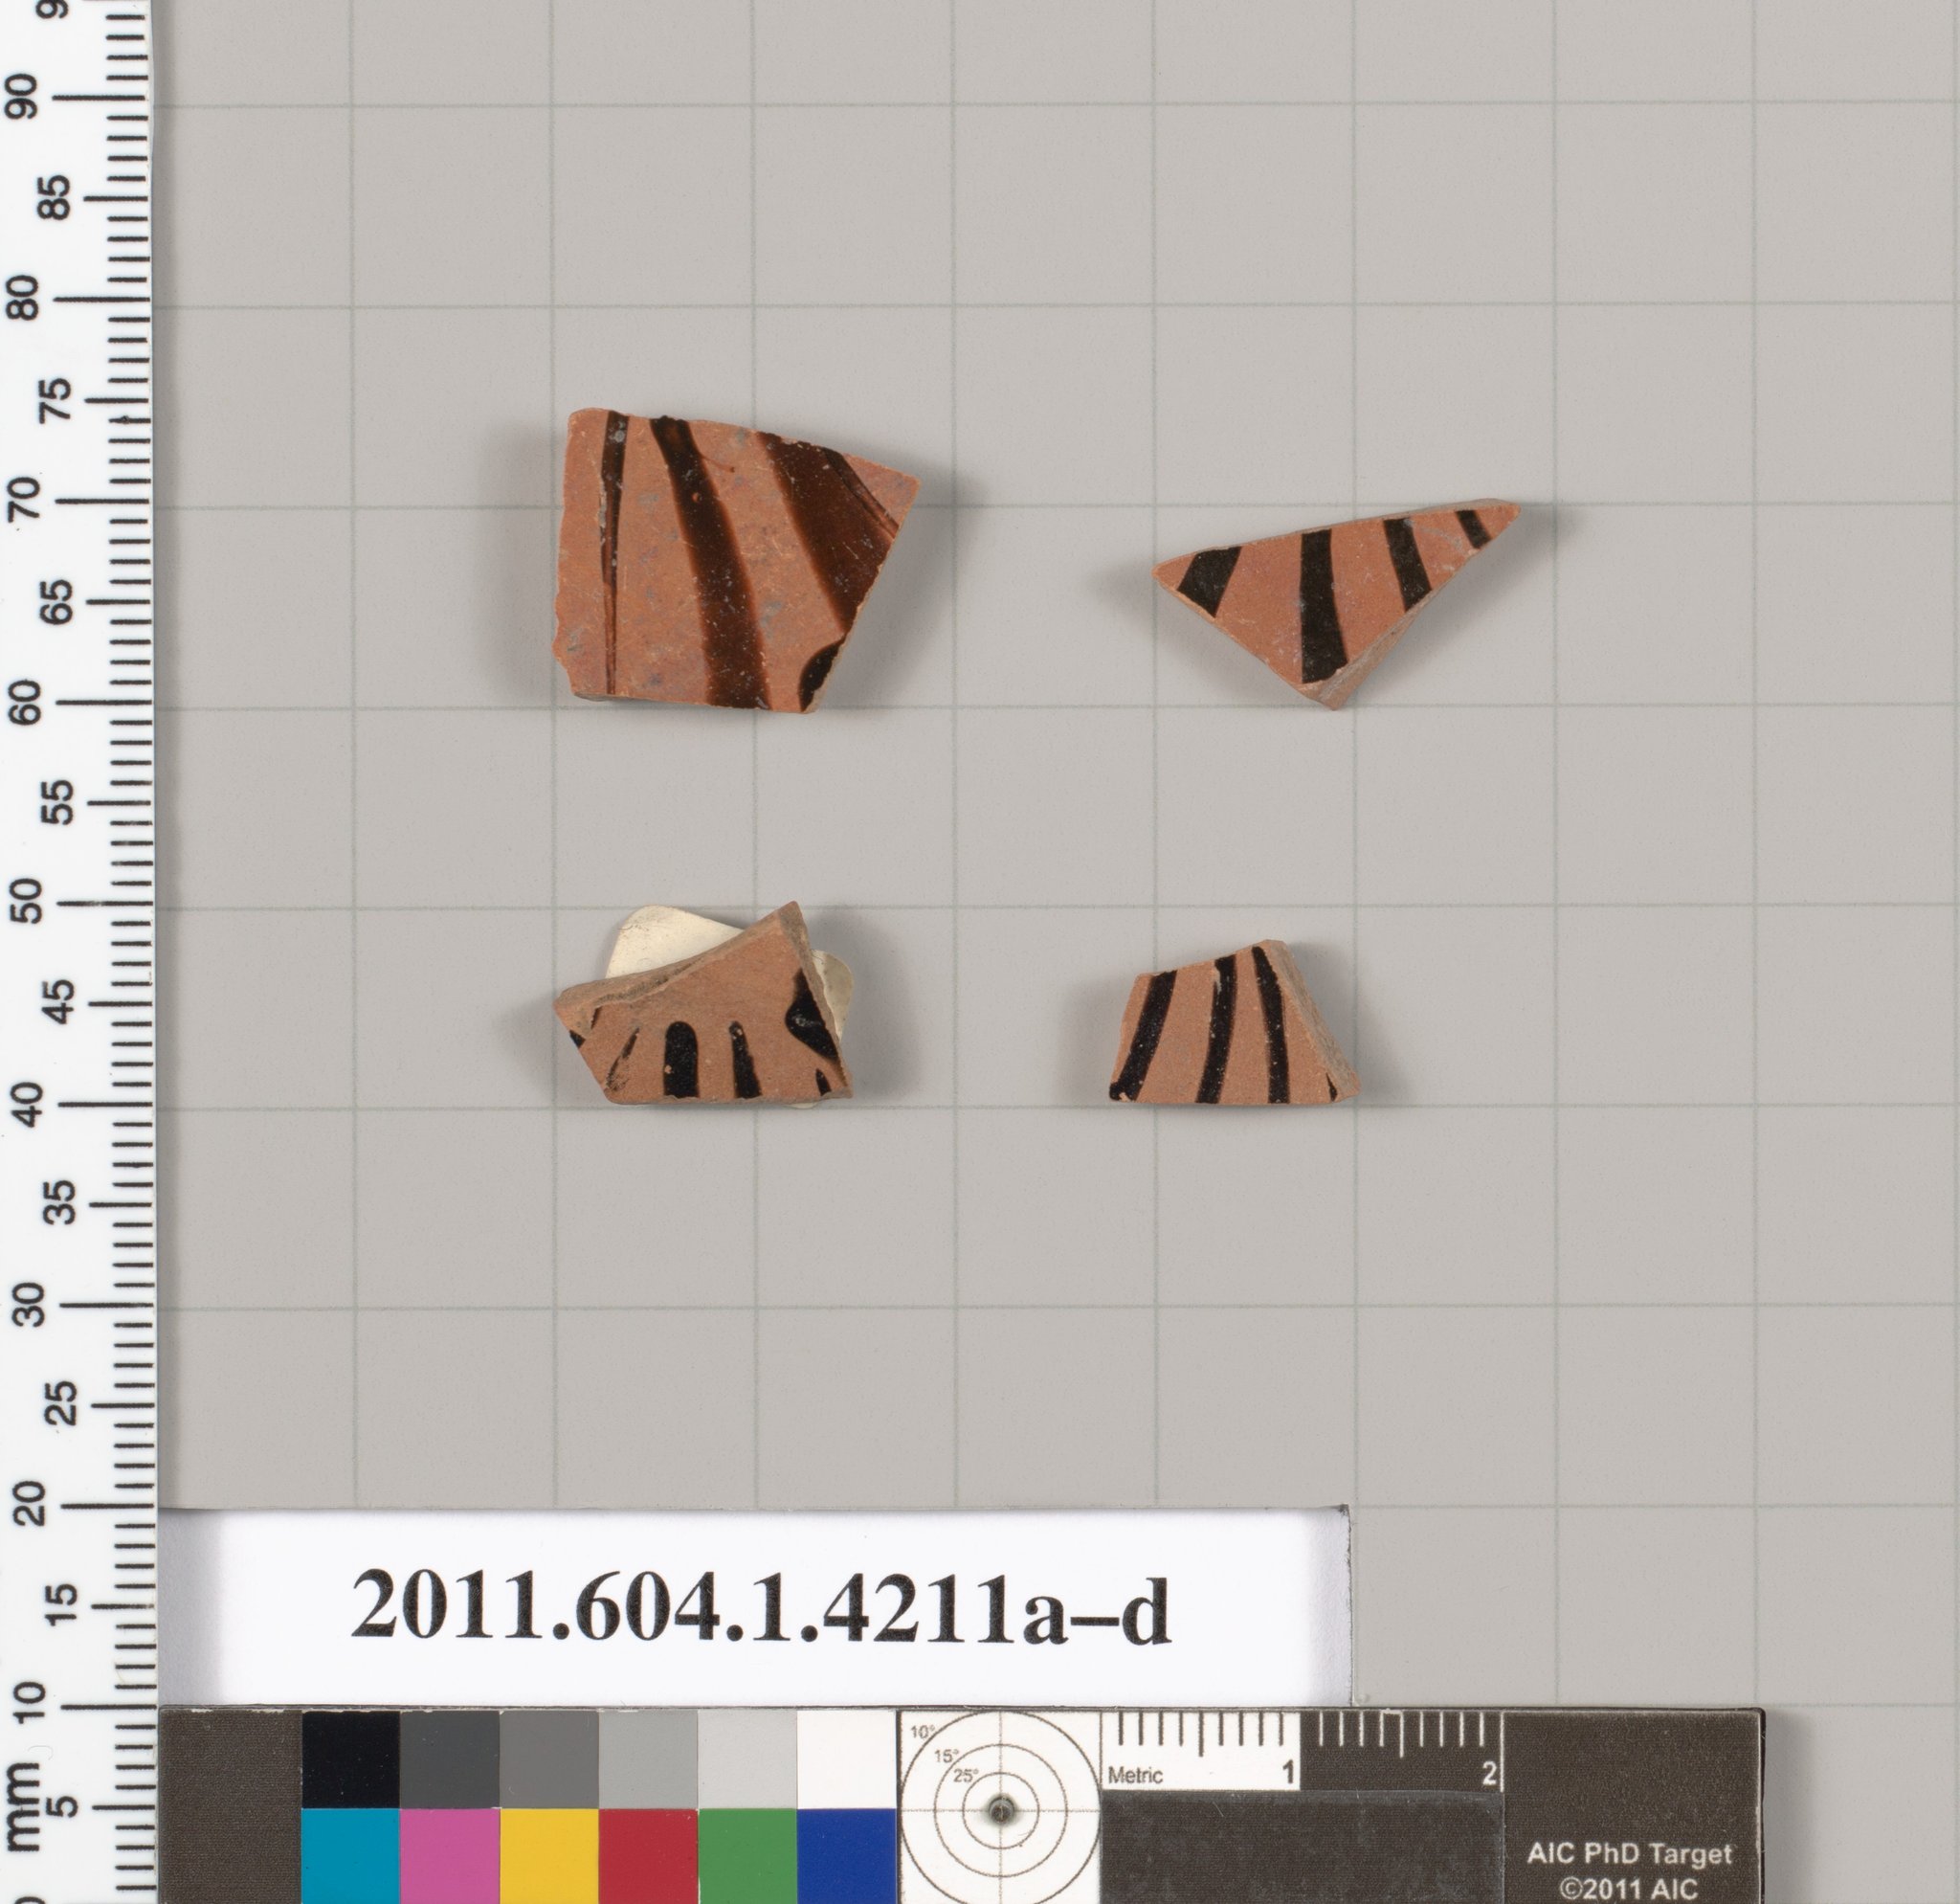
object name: kylix fragment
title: Terracotta fragments of kylikes (drinking cups)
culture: greek, attic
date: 475-451 BCE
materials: terracotta